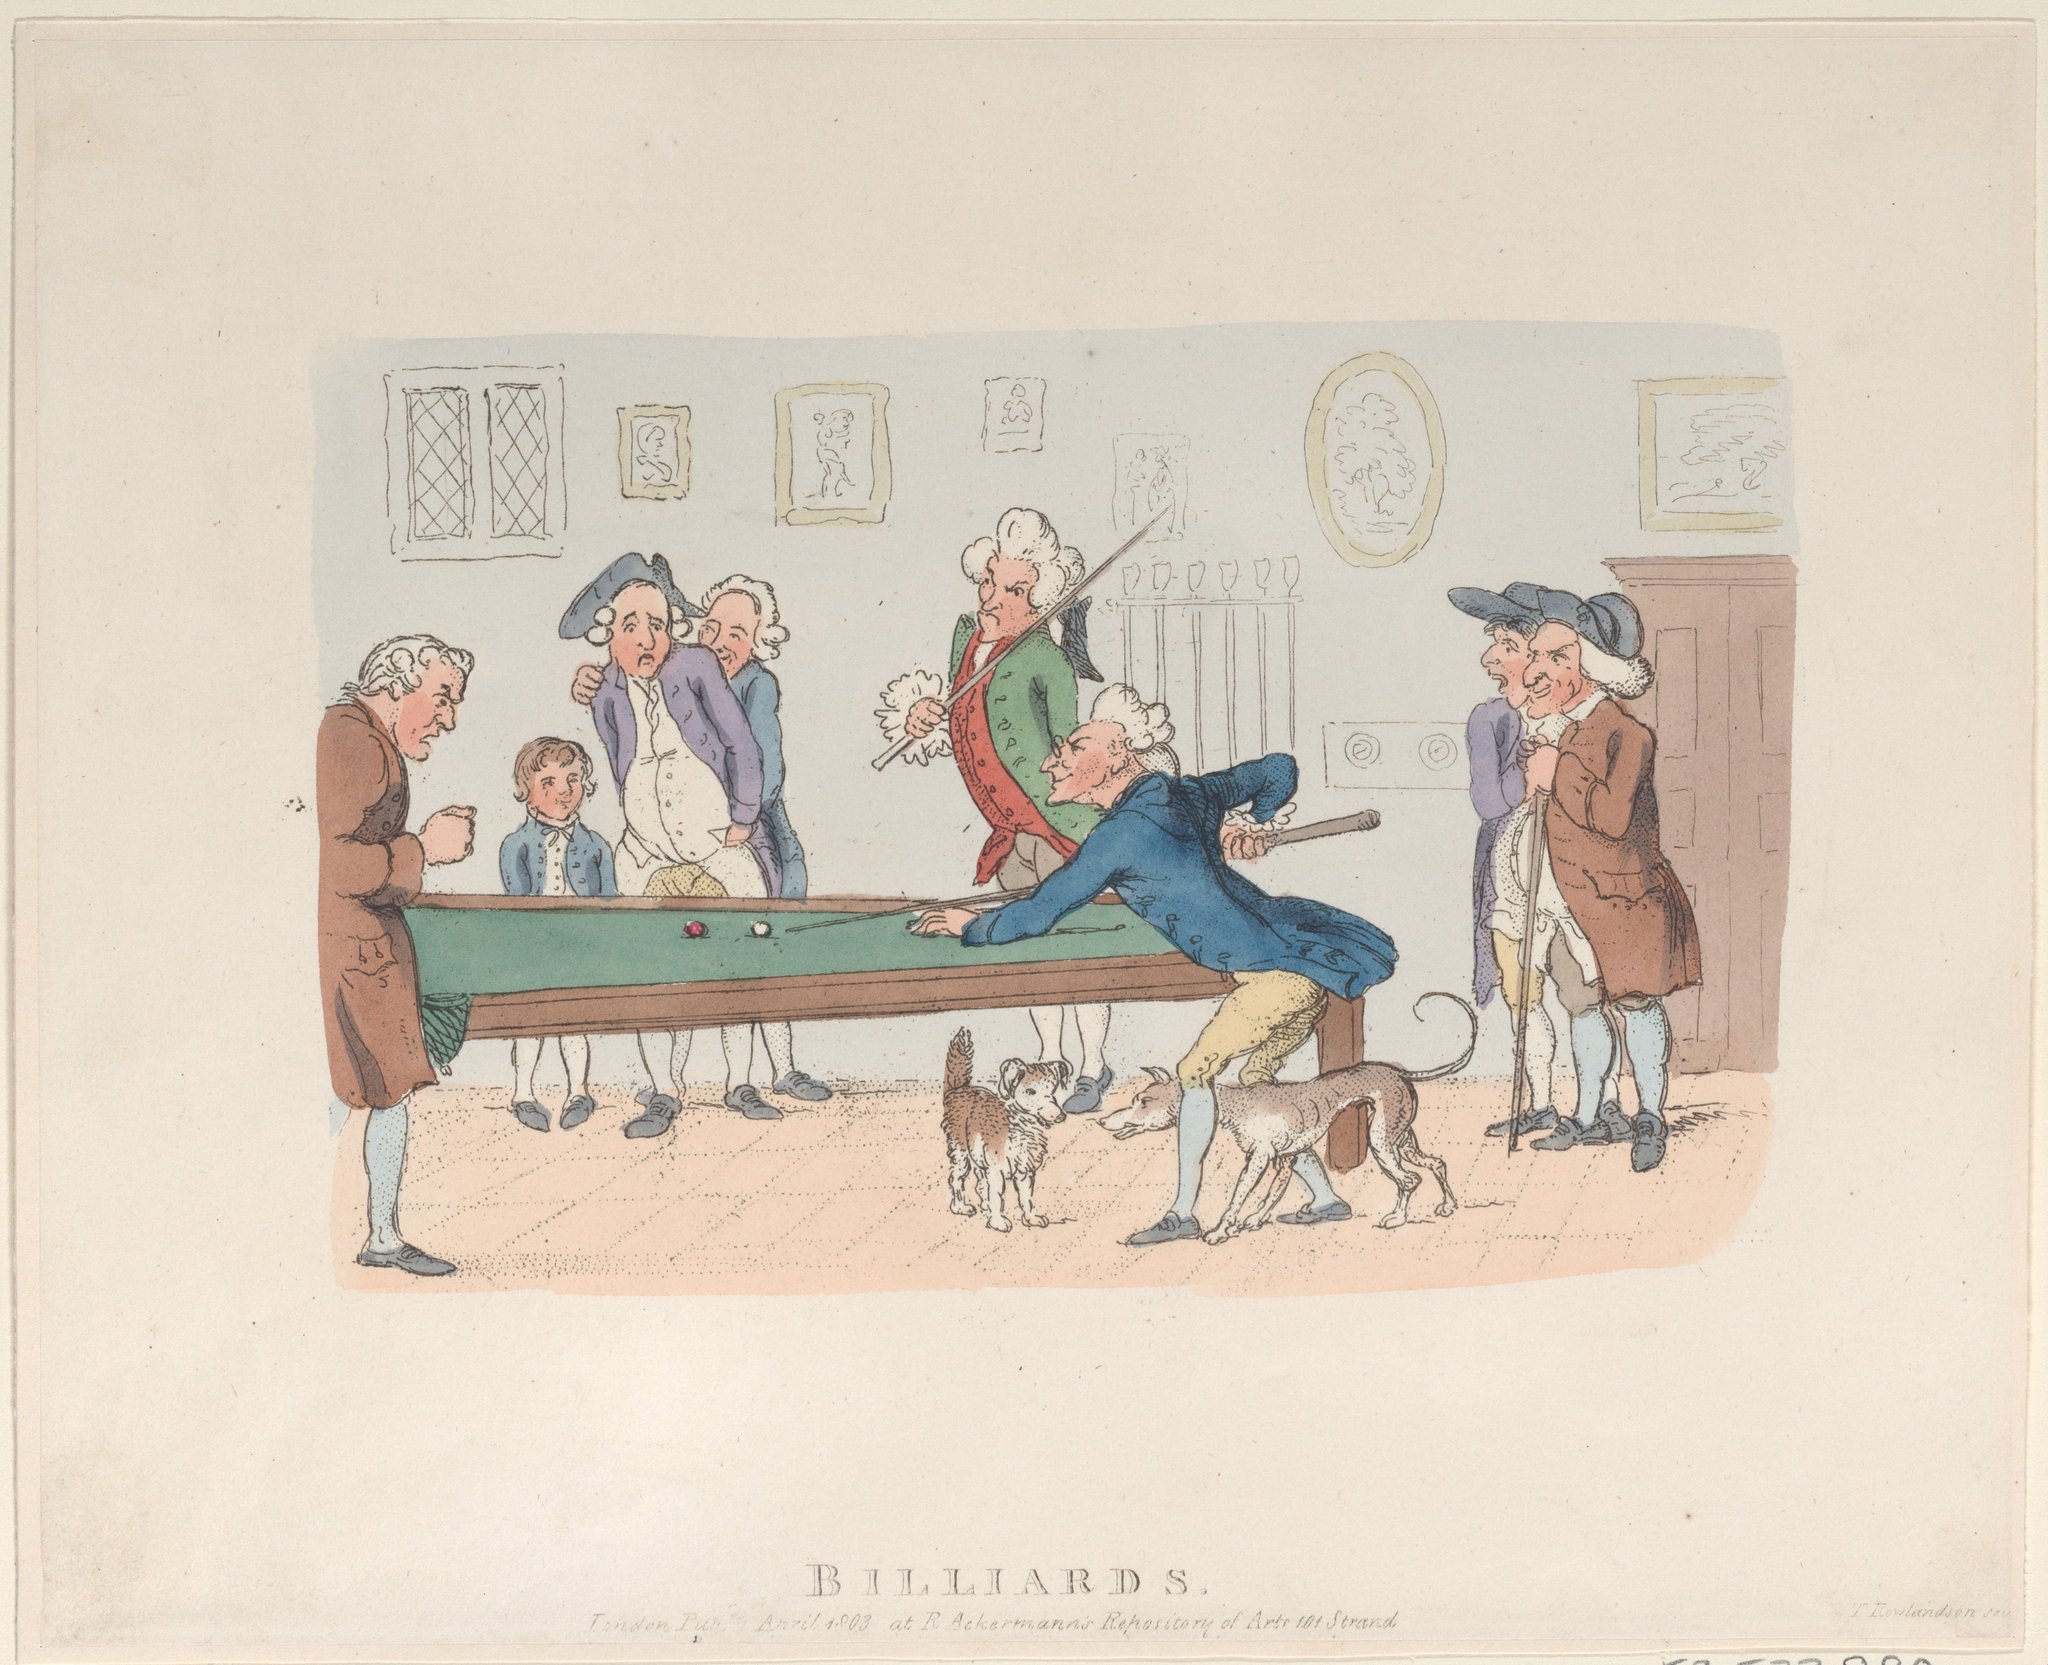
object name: print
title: Billards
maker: thomas rowlandson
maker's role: artist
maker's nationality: british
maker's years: 1757-1827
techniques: etching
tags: satire,men,billiards,dogs